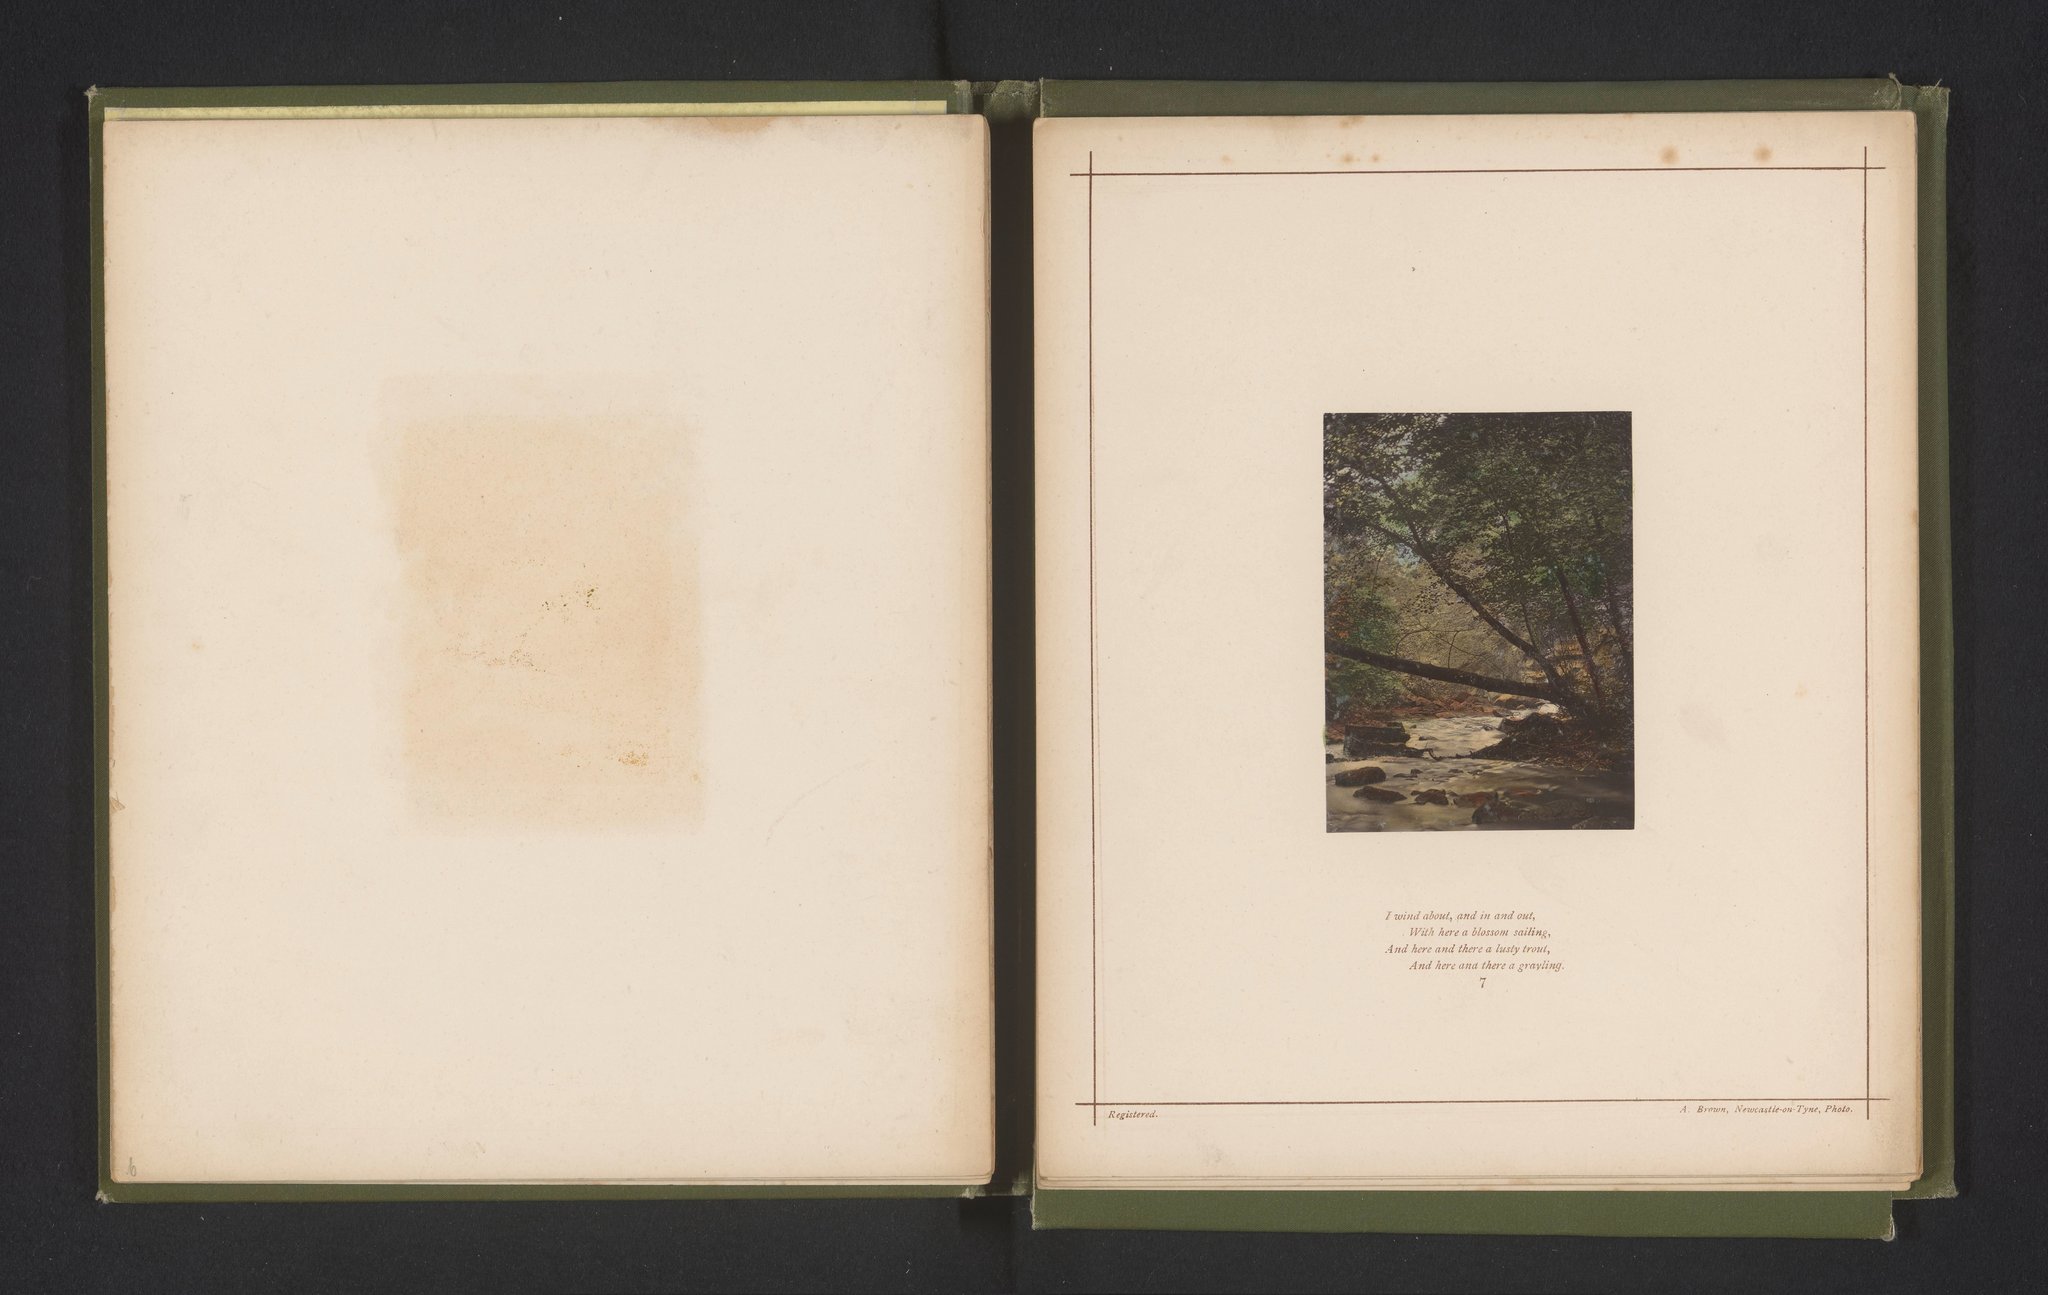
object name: photograph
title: Gezicht op de beek Skelton Beck nabij Saltburn-by-the-Sea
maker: arthur brown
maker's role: fotograaf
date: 1874-1879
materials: paper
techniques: carbon print, hand coloring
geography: north yorkshire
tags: brook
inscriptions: number: ‘7’, inscription: ‘I wind about (...) there a grayling.’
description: Deze foto maakt deel uit van een omslag met dertien foto's.